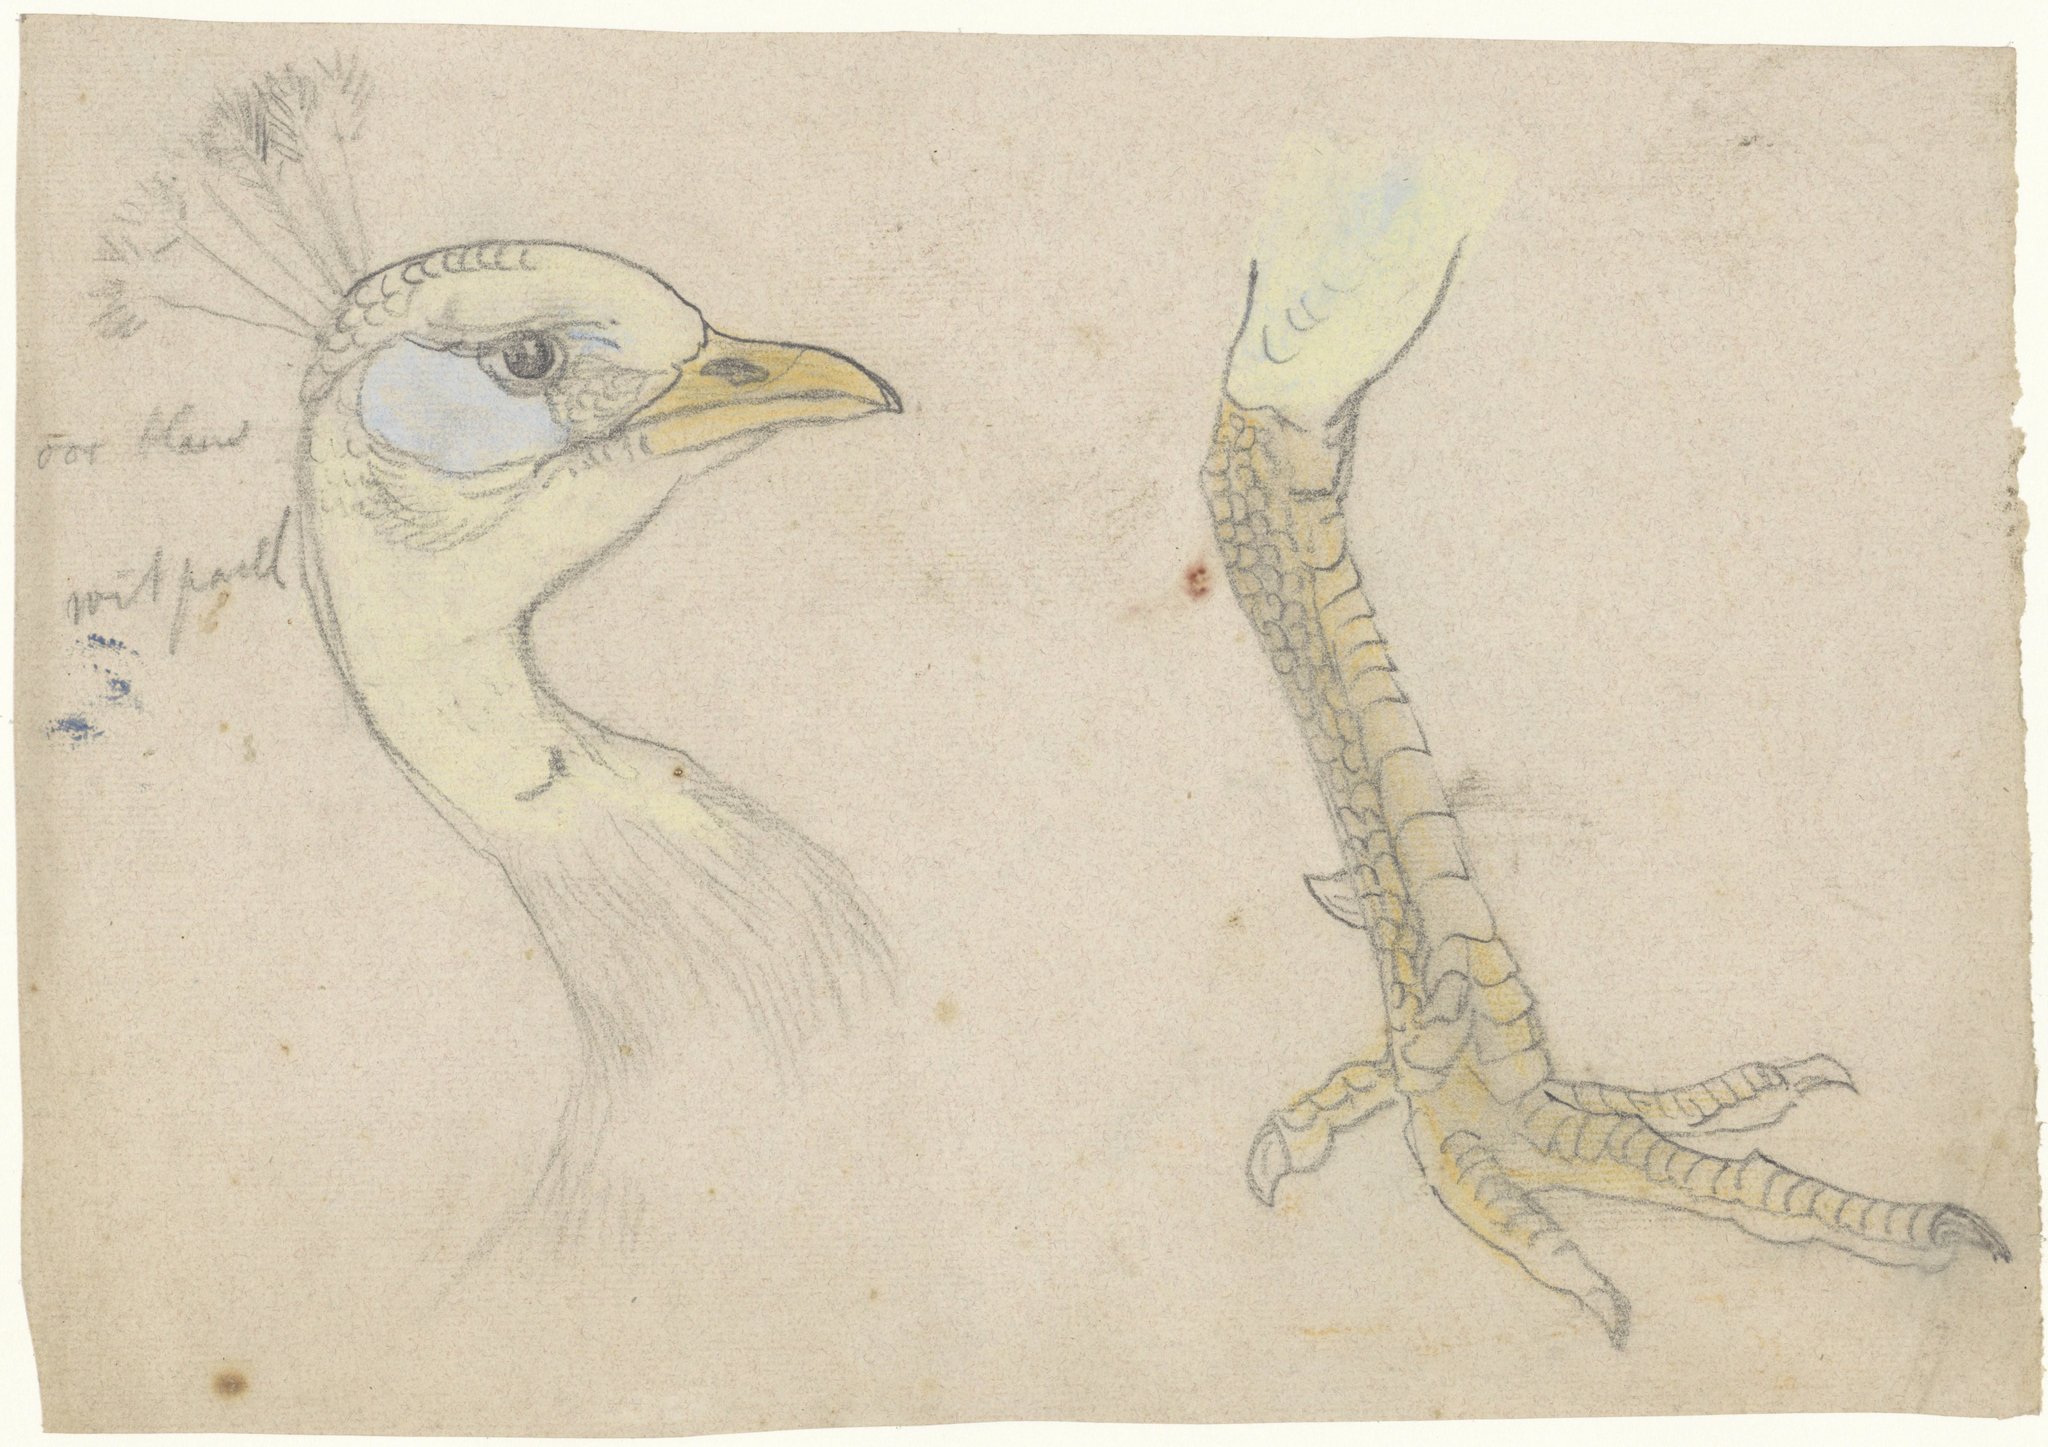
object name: drawing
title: Kop en poot van een pauw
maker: theo van hoytema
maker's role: draughtsman, painter, print maker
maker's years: 1863-1917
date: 1873-1917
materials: chalk, paper, pastel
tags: ornamental birds: peacock